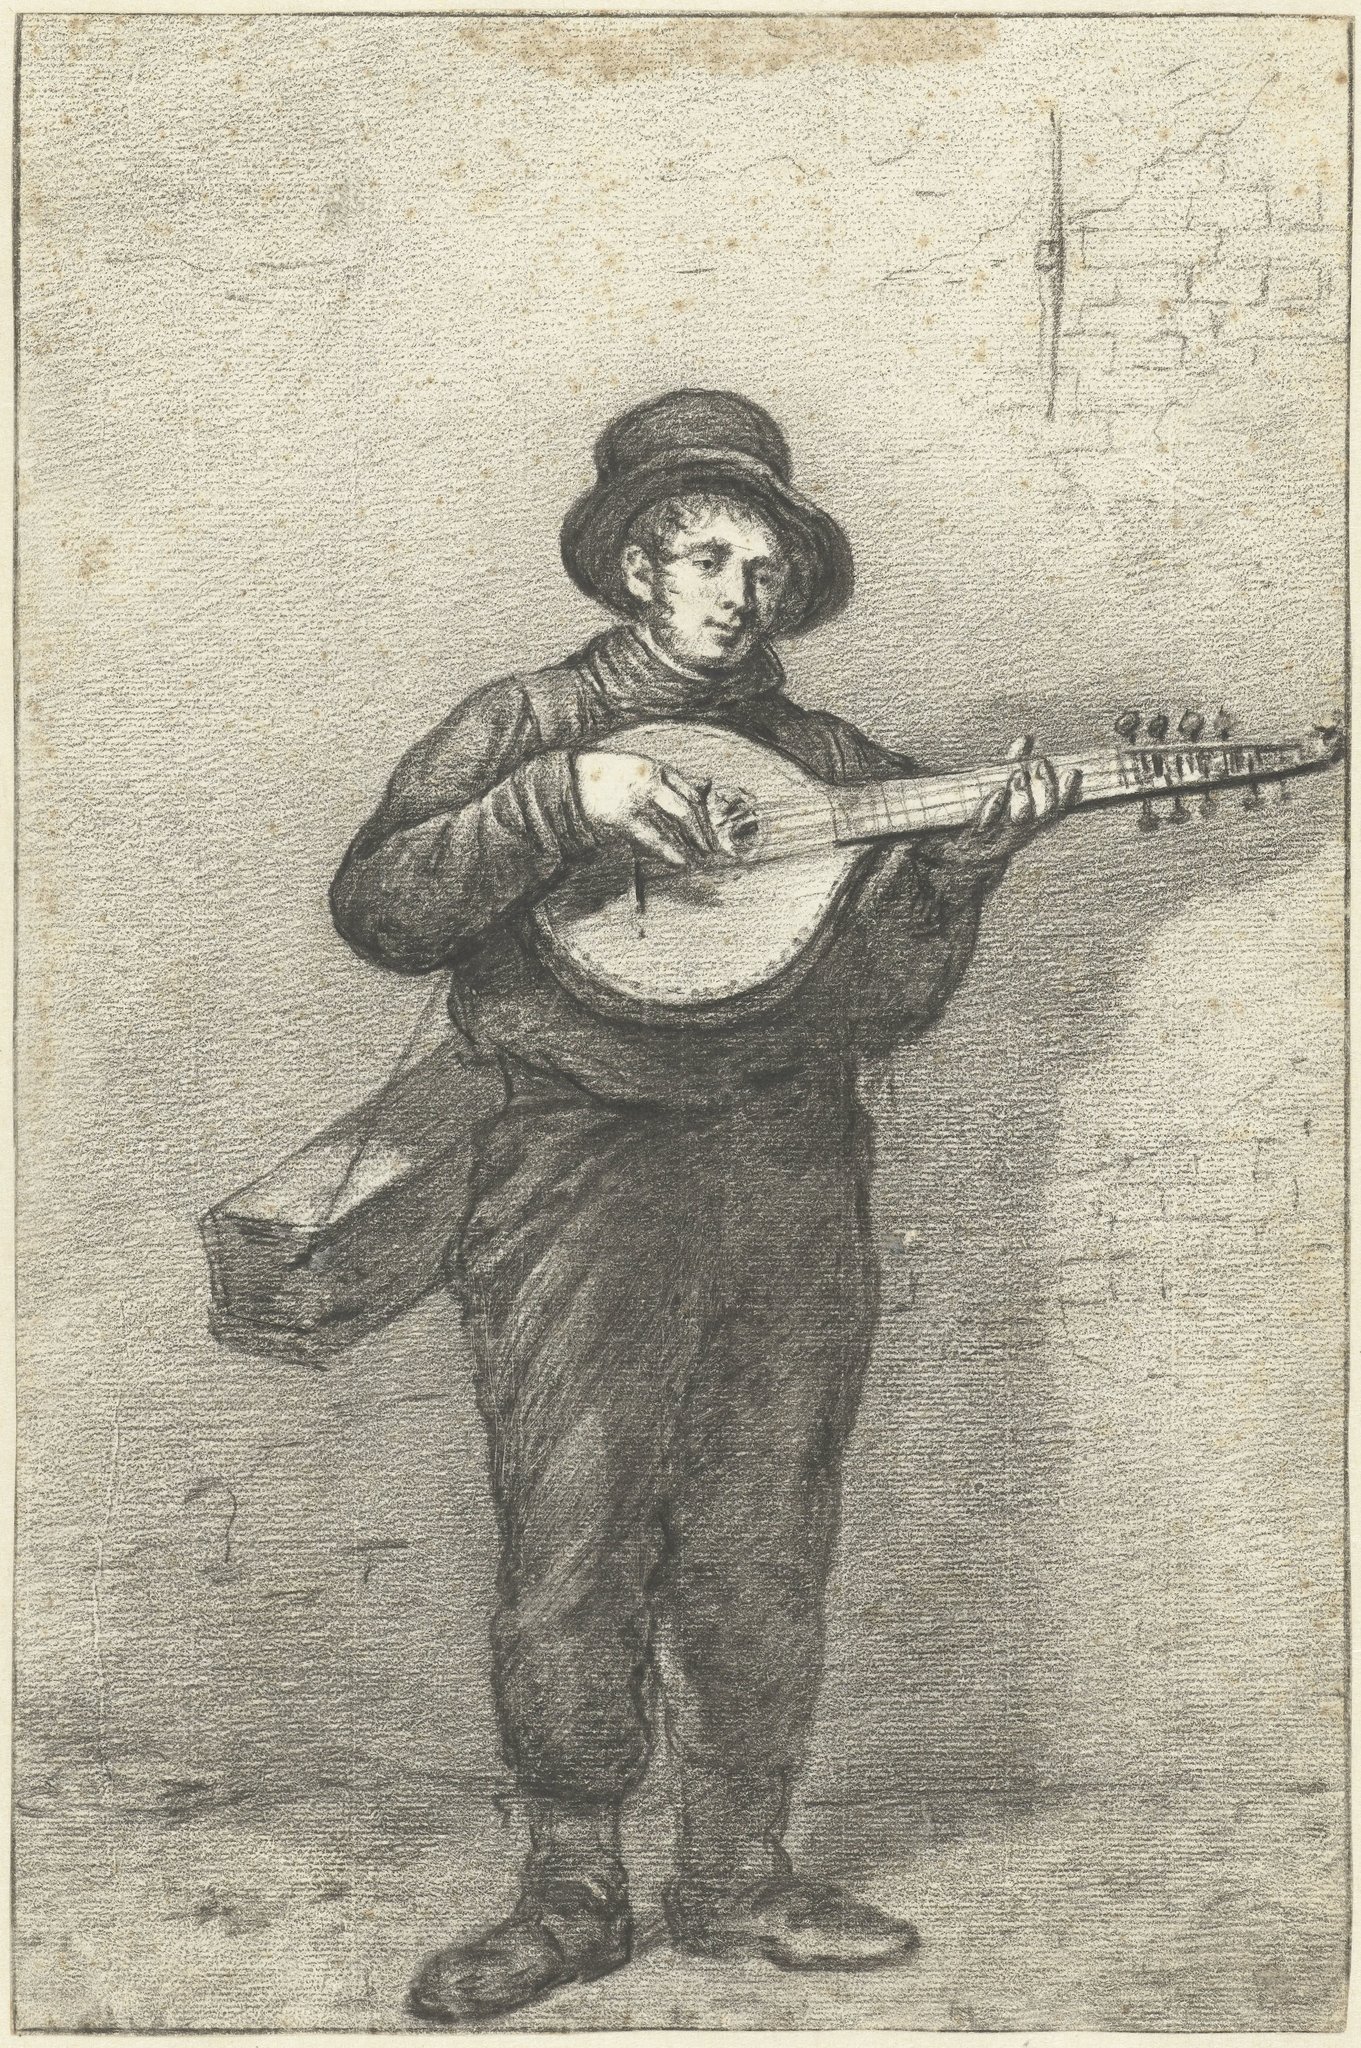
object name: drawing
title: Straatmuzikant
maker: willem albertus haanebrink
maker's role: draughtsman, print maker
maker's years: 1762-1840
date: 1772-1840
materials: chalk, paper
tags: one person playing string instrument (plucked), popular music, street music, lute, and special forms of lute, e.g.: theorbo